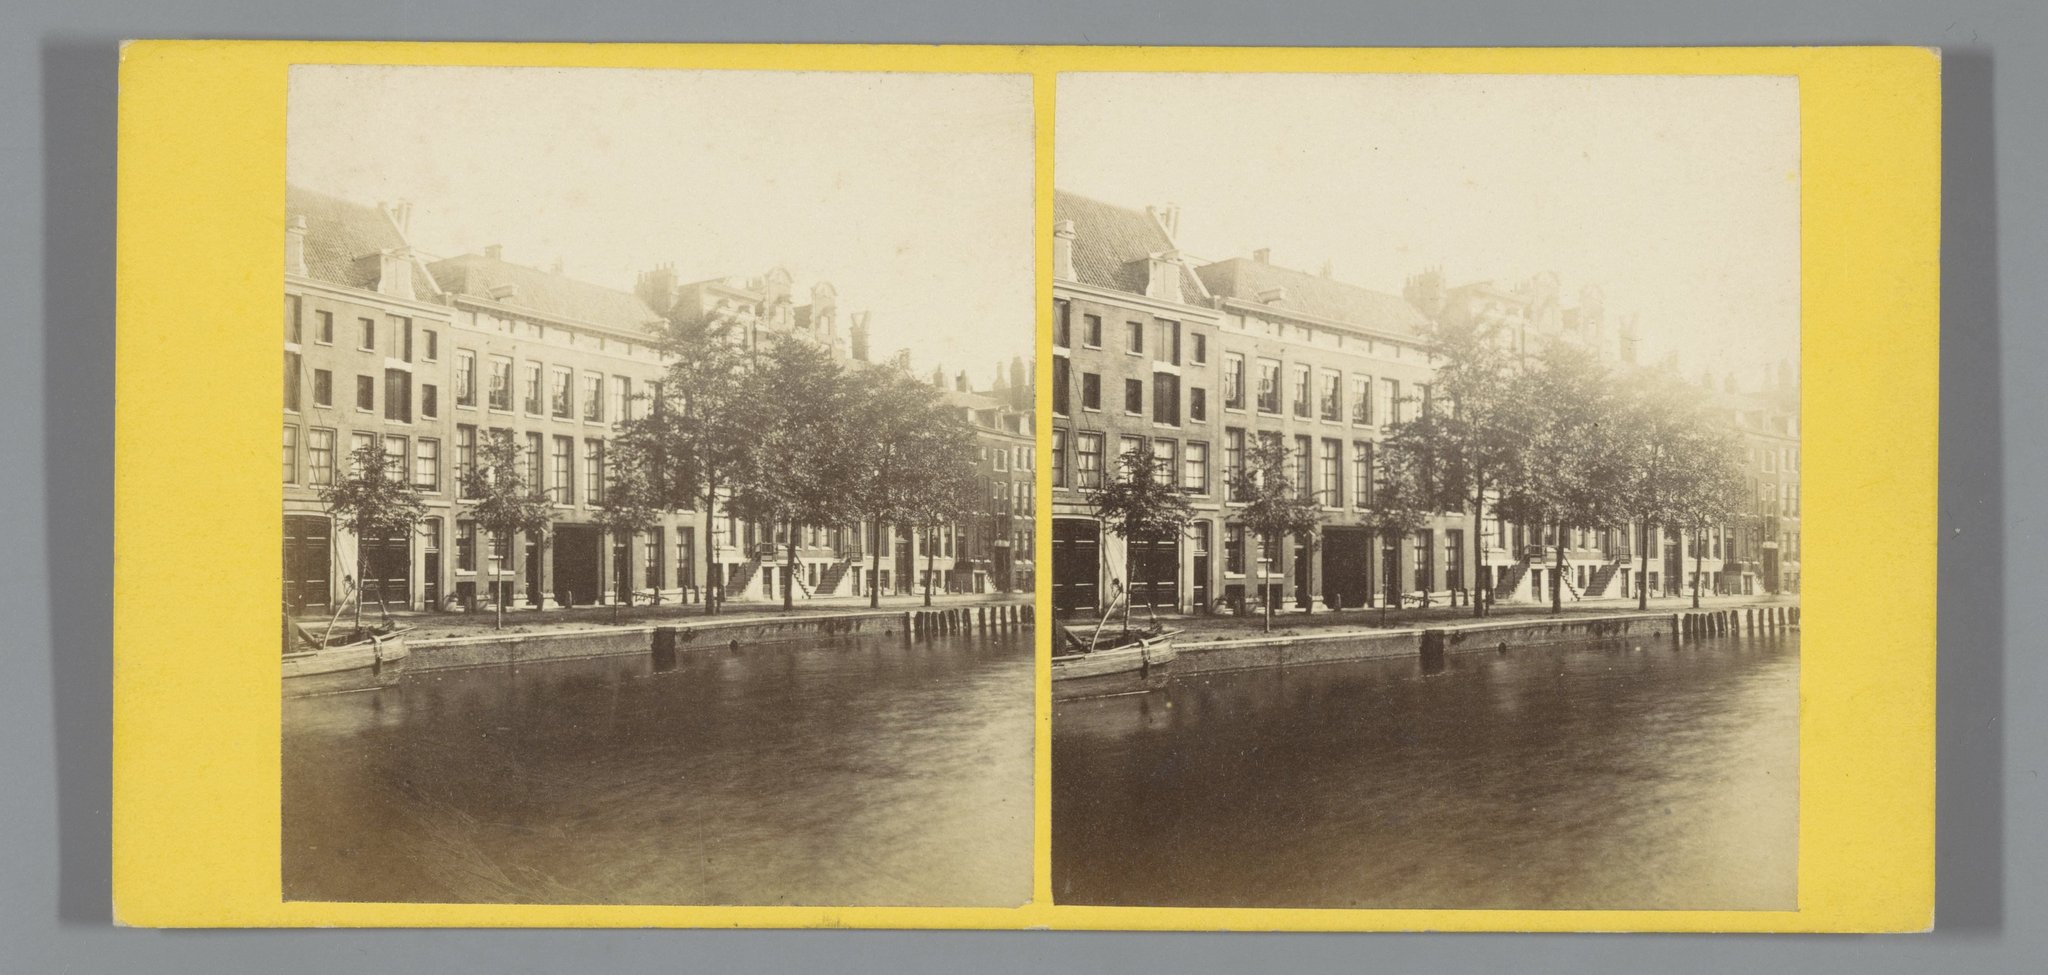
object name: stereograph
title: Gezicht op de Keizersgracht nummer 493 tot en met nummer 497 in Amsterdam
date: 1860-1885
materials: cardboard, photographic support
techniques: albumen print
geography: amsterdam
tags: street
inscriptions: inscription: ‘Uitgegeven bij A. JAGER, Water 110, te Amsterdam.’, annotation: ‘Amsterdam Keizersgracht 497 en bij/ Leidsestraat’